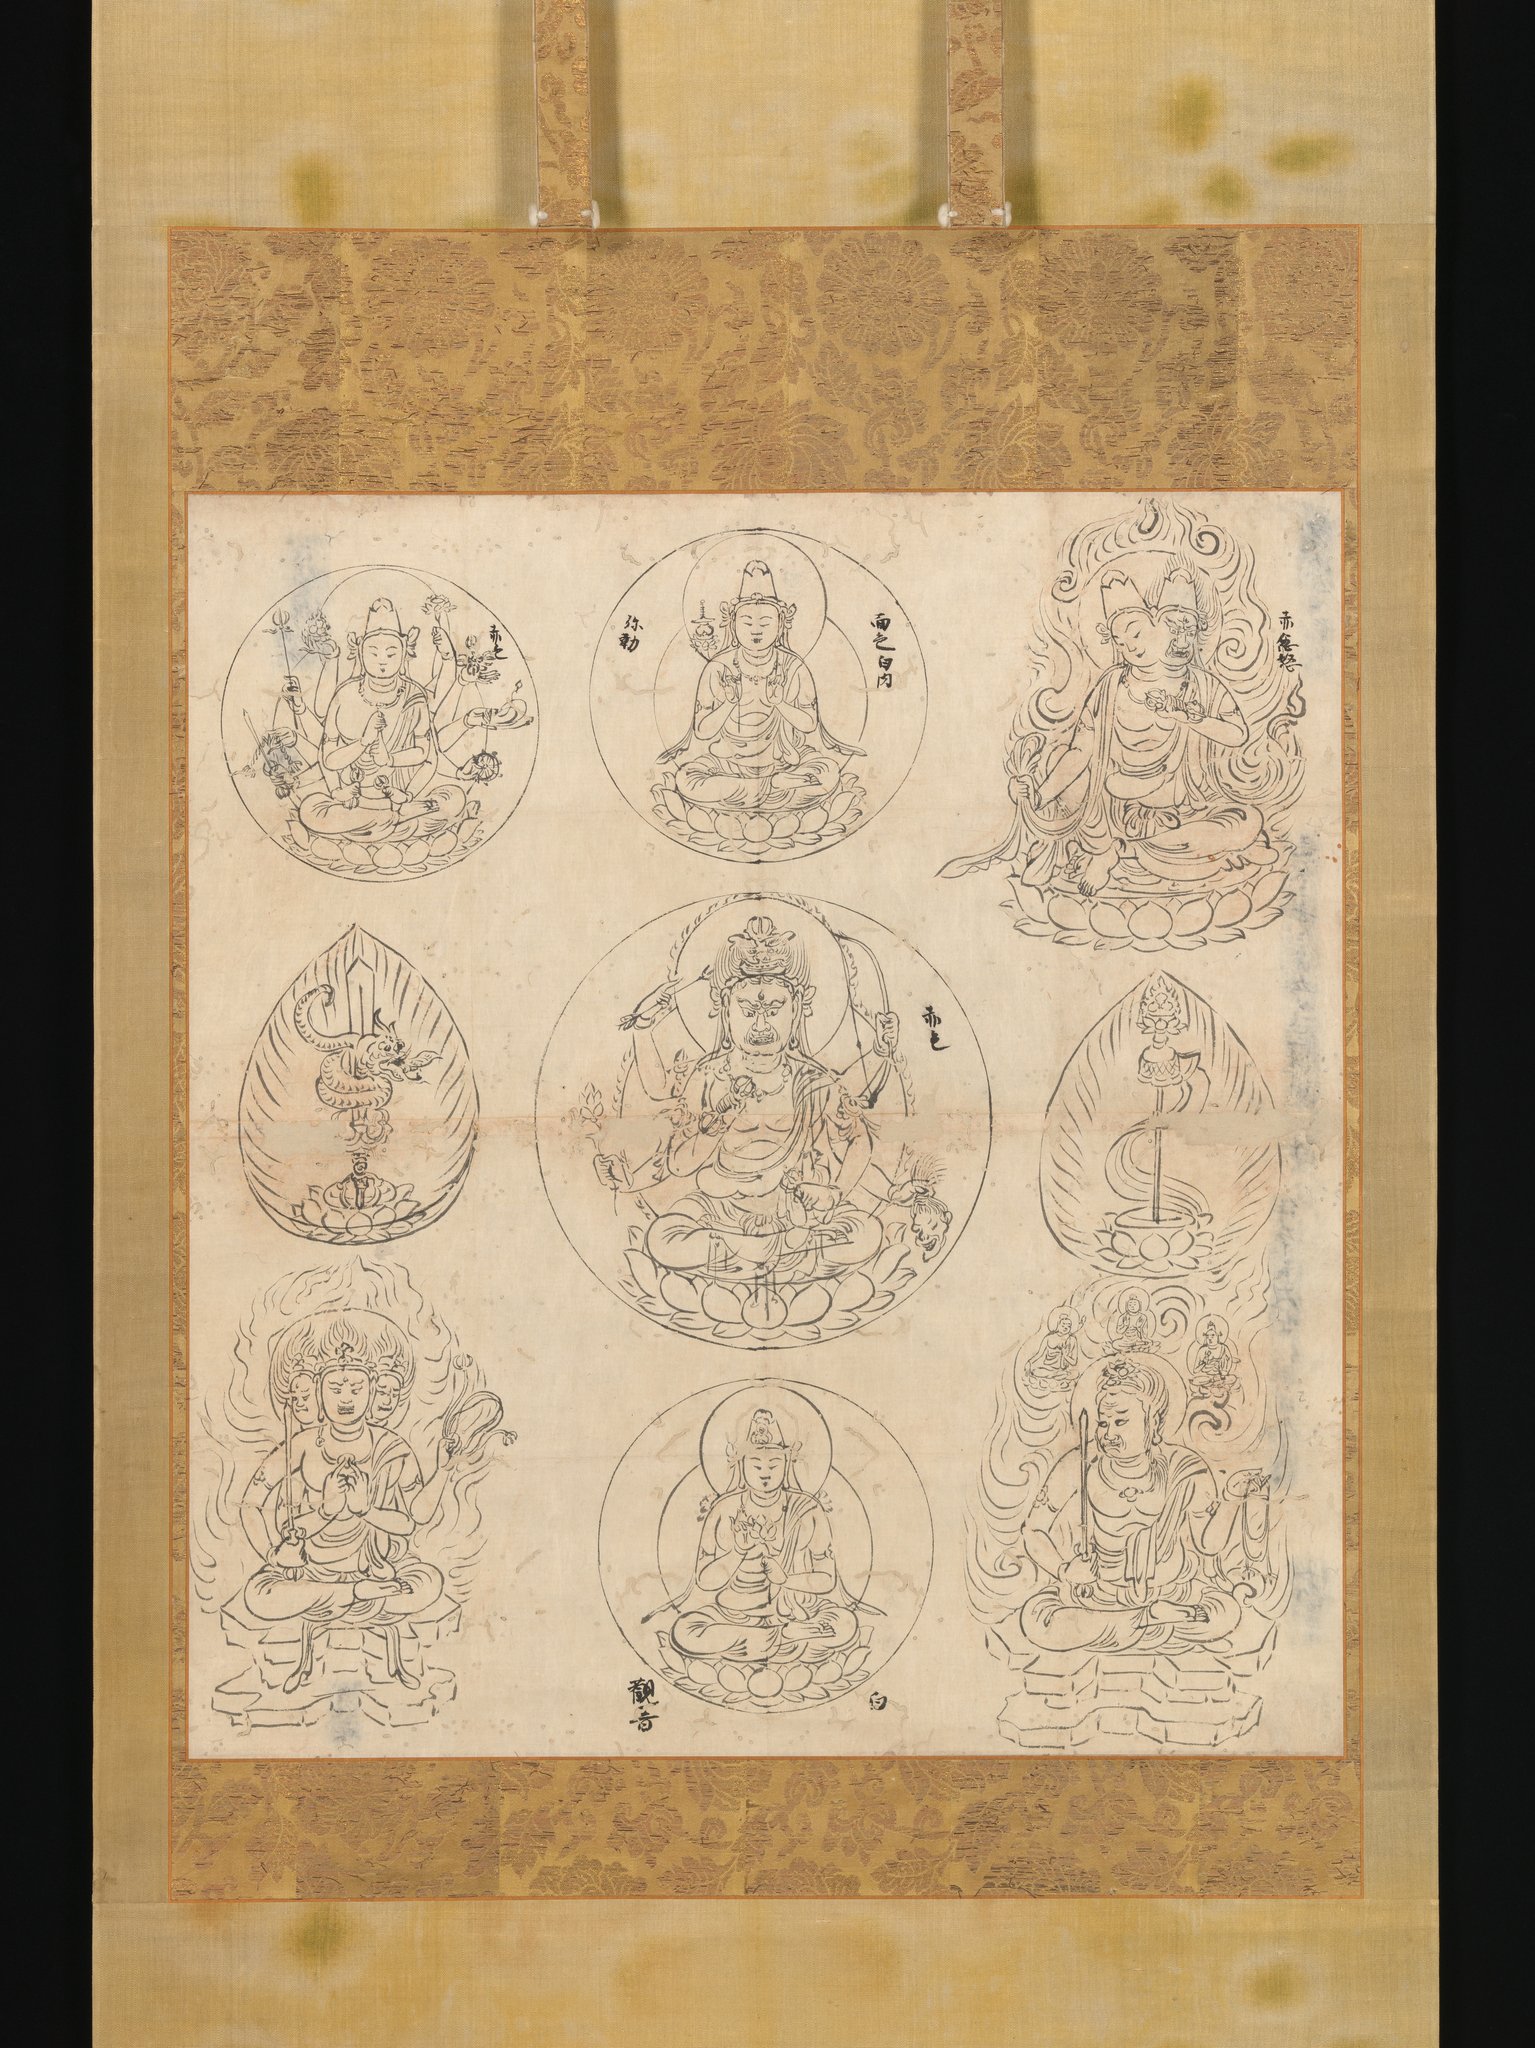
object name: hanging scroll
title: Iconographical Drawing of the Mandala of the Wisdom King Aizen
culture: japanese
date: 1107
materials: ink, paper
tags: buddhism,bodhisattvas,deities